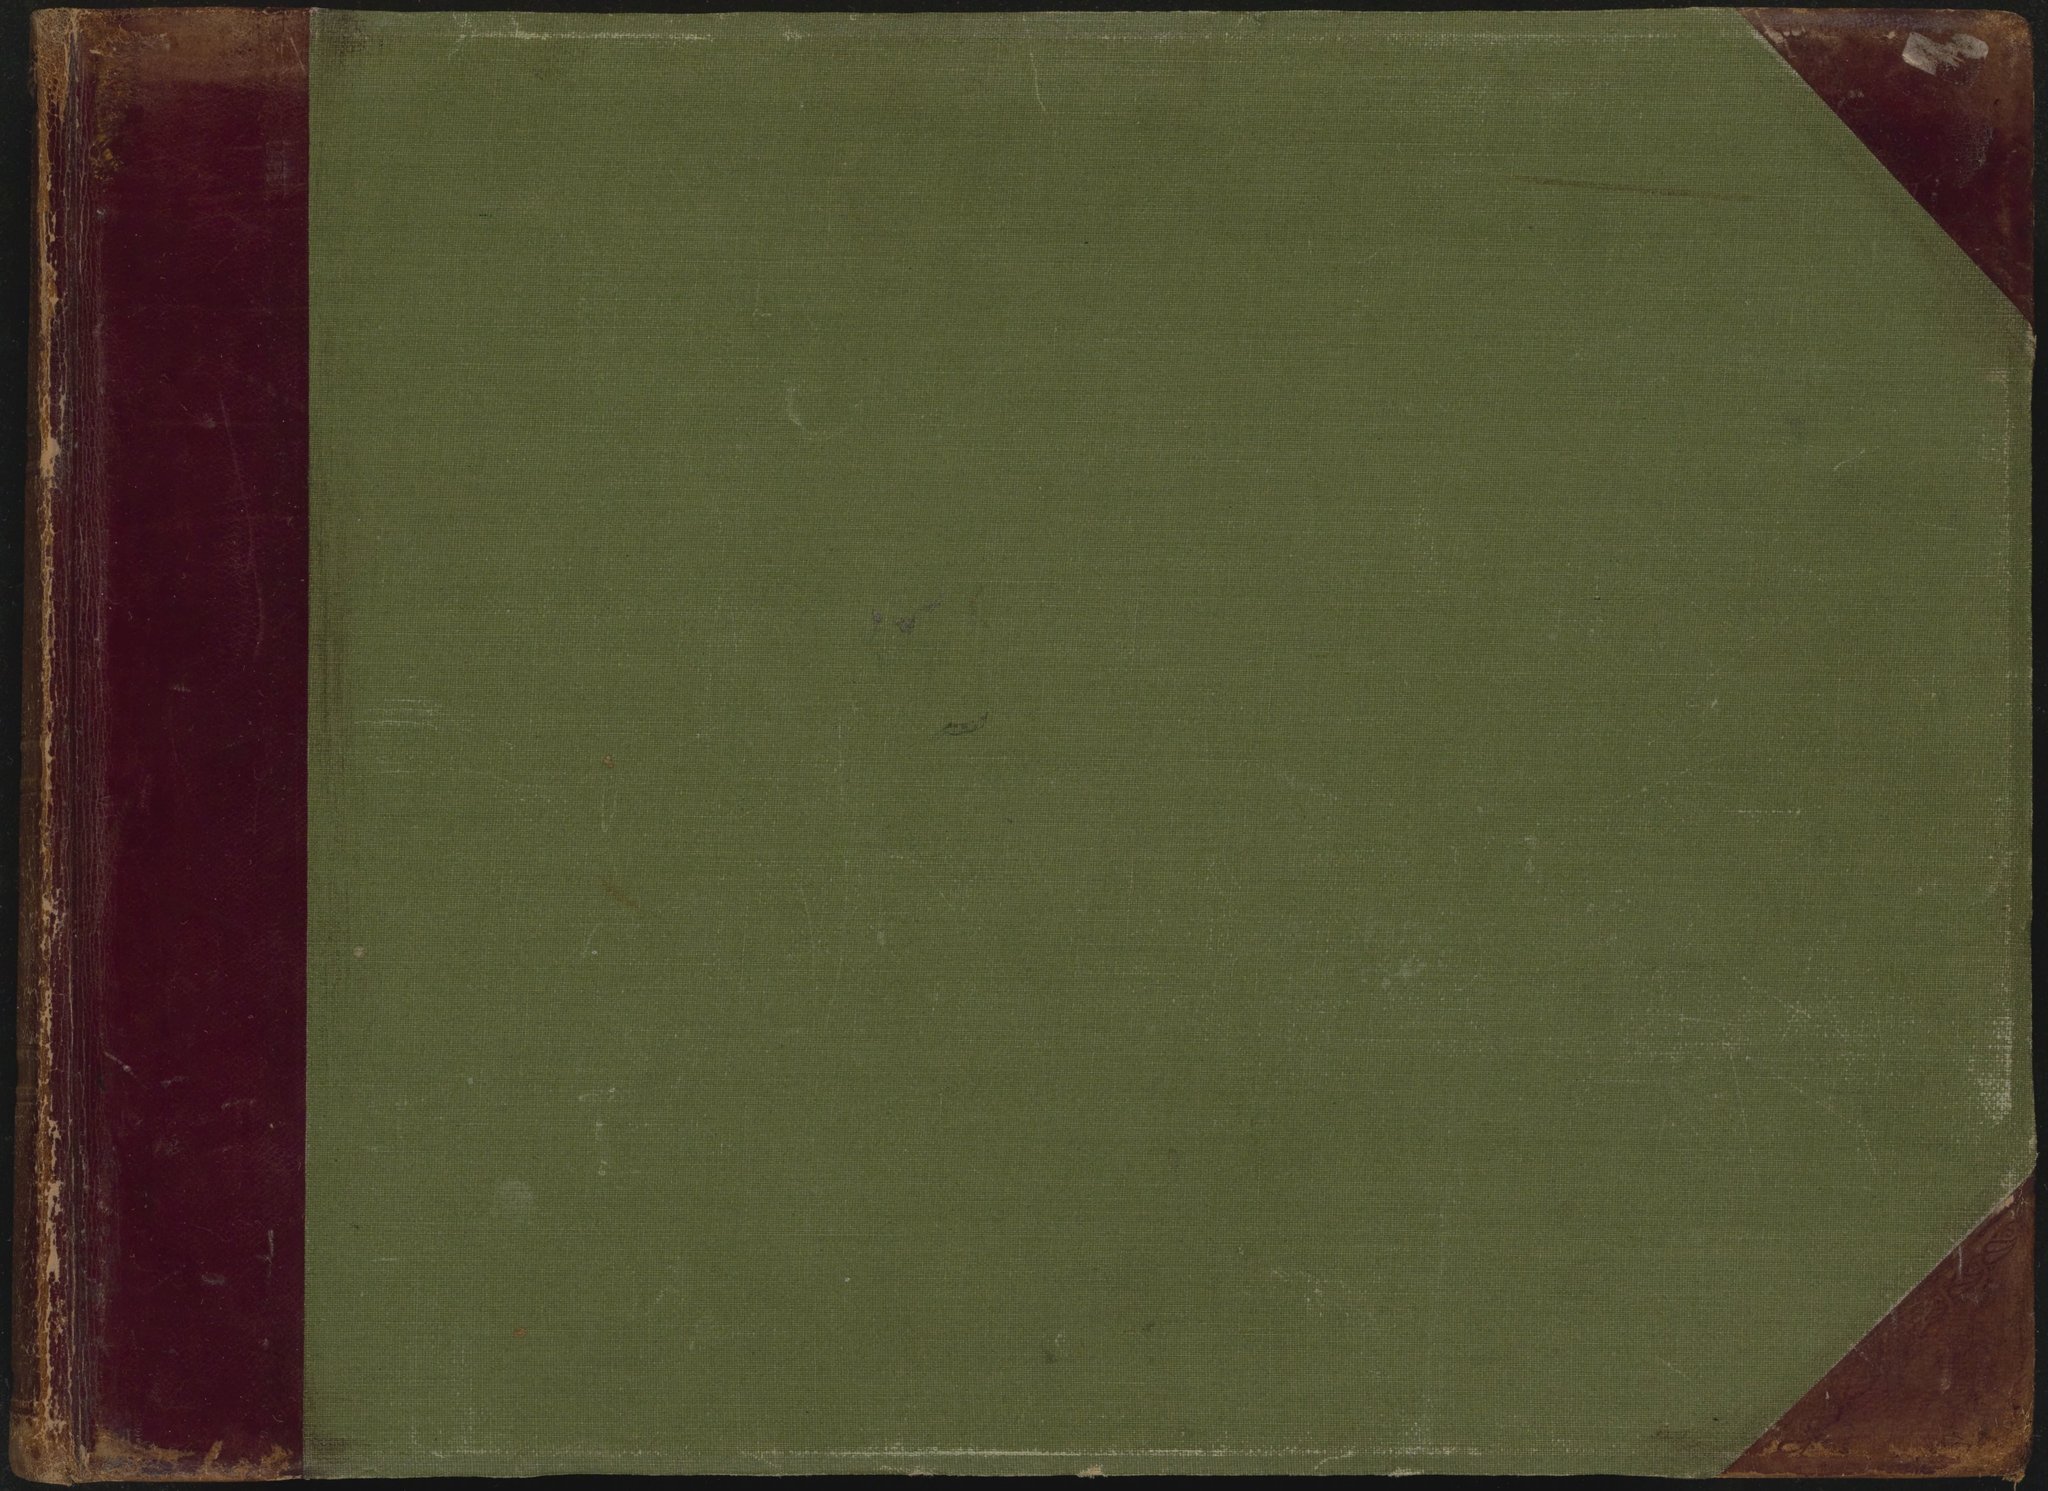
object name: scrapbook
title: Fotoalbum van de familie Palthe uit Almelo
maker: Anonymous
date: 1910-1915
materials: cardboard, leather, linen, paper, photographic support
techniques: gelatin silver print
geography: netherlands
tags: the family travelling, on holiday, recreation, historical persons, village, family life, family life at home, netherlands, europe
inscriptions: inscription: ‘Album familie Palthe Almelo’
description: Fotoalbum in een groene linnen band met leren rug en hoekpunten. Schutbladen hebben een bloemmotief in art nouveaustijl. Het album bevat dertig blauwgrijze kartonnen bladen met 157 opgeplakte foto's waarvan enkele met een bijschrift. Het zijn opnames van leden van de familie Palthe uit Almelo, van het dorpsleven in Ommen, van de aanleg van een waterwerk, van wandel- en vaartochten, van een reis naar Zuid-Europa en Tanger en van de bruiloft van Jan en Liesbeth Croockewit. Ook vijf albumbladen met foto's van tapijten en beklede stoelen.